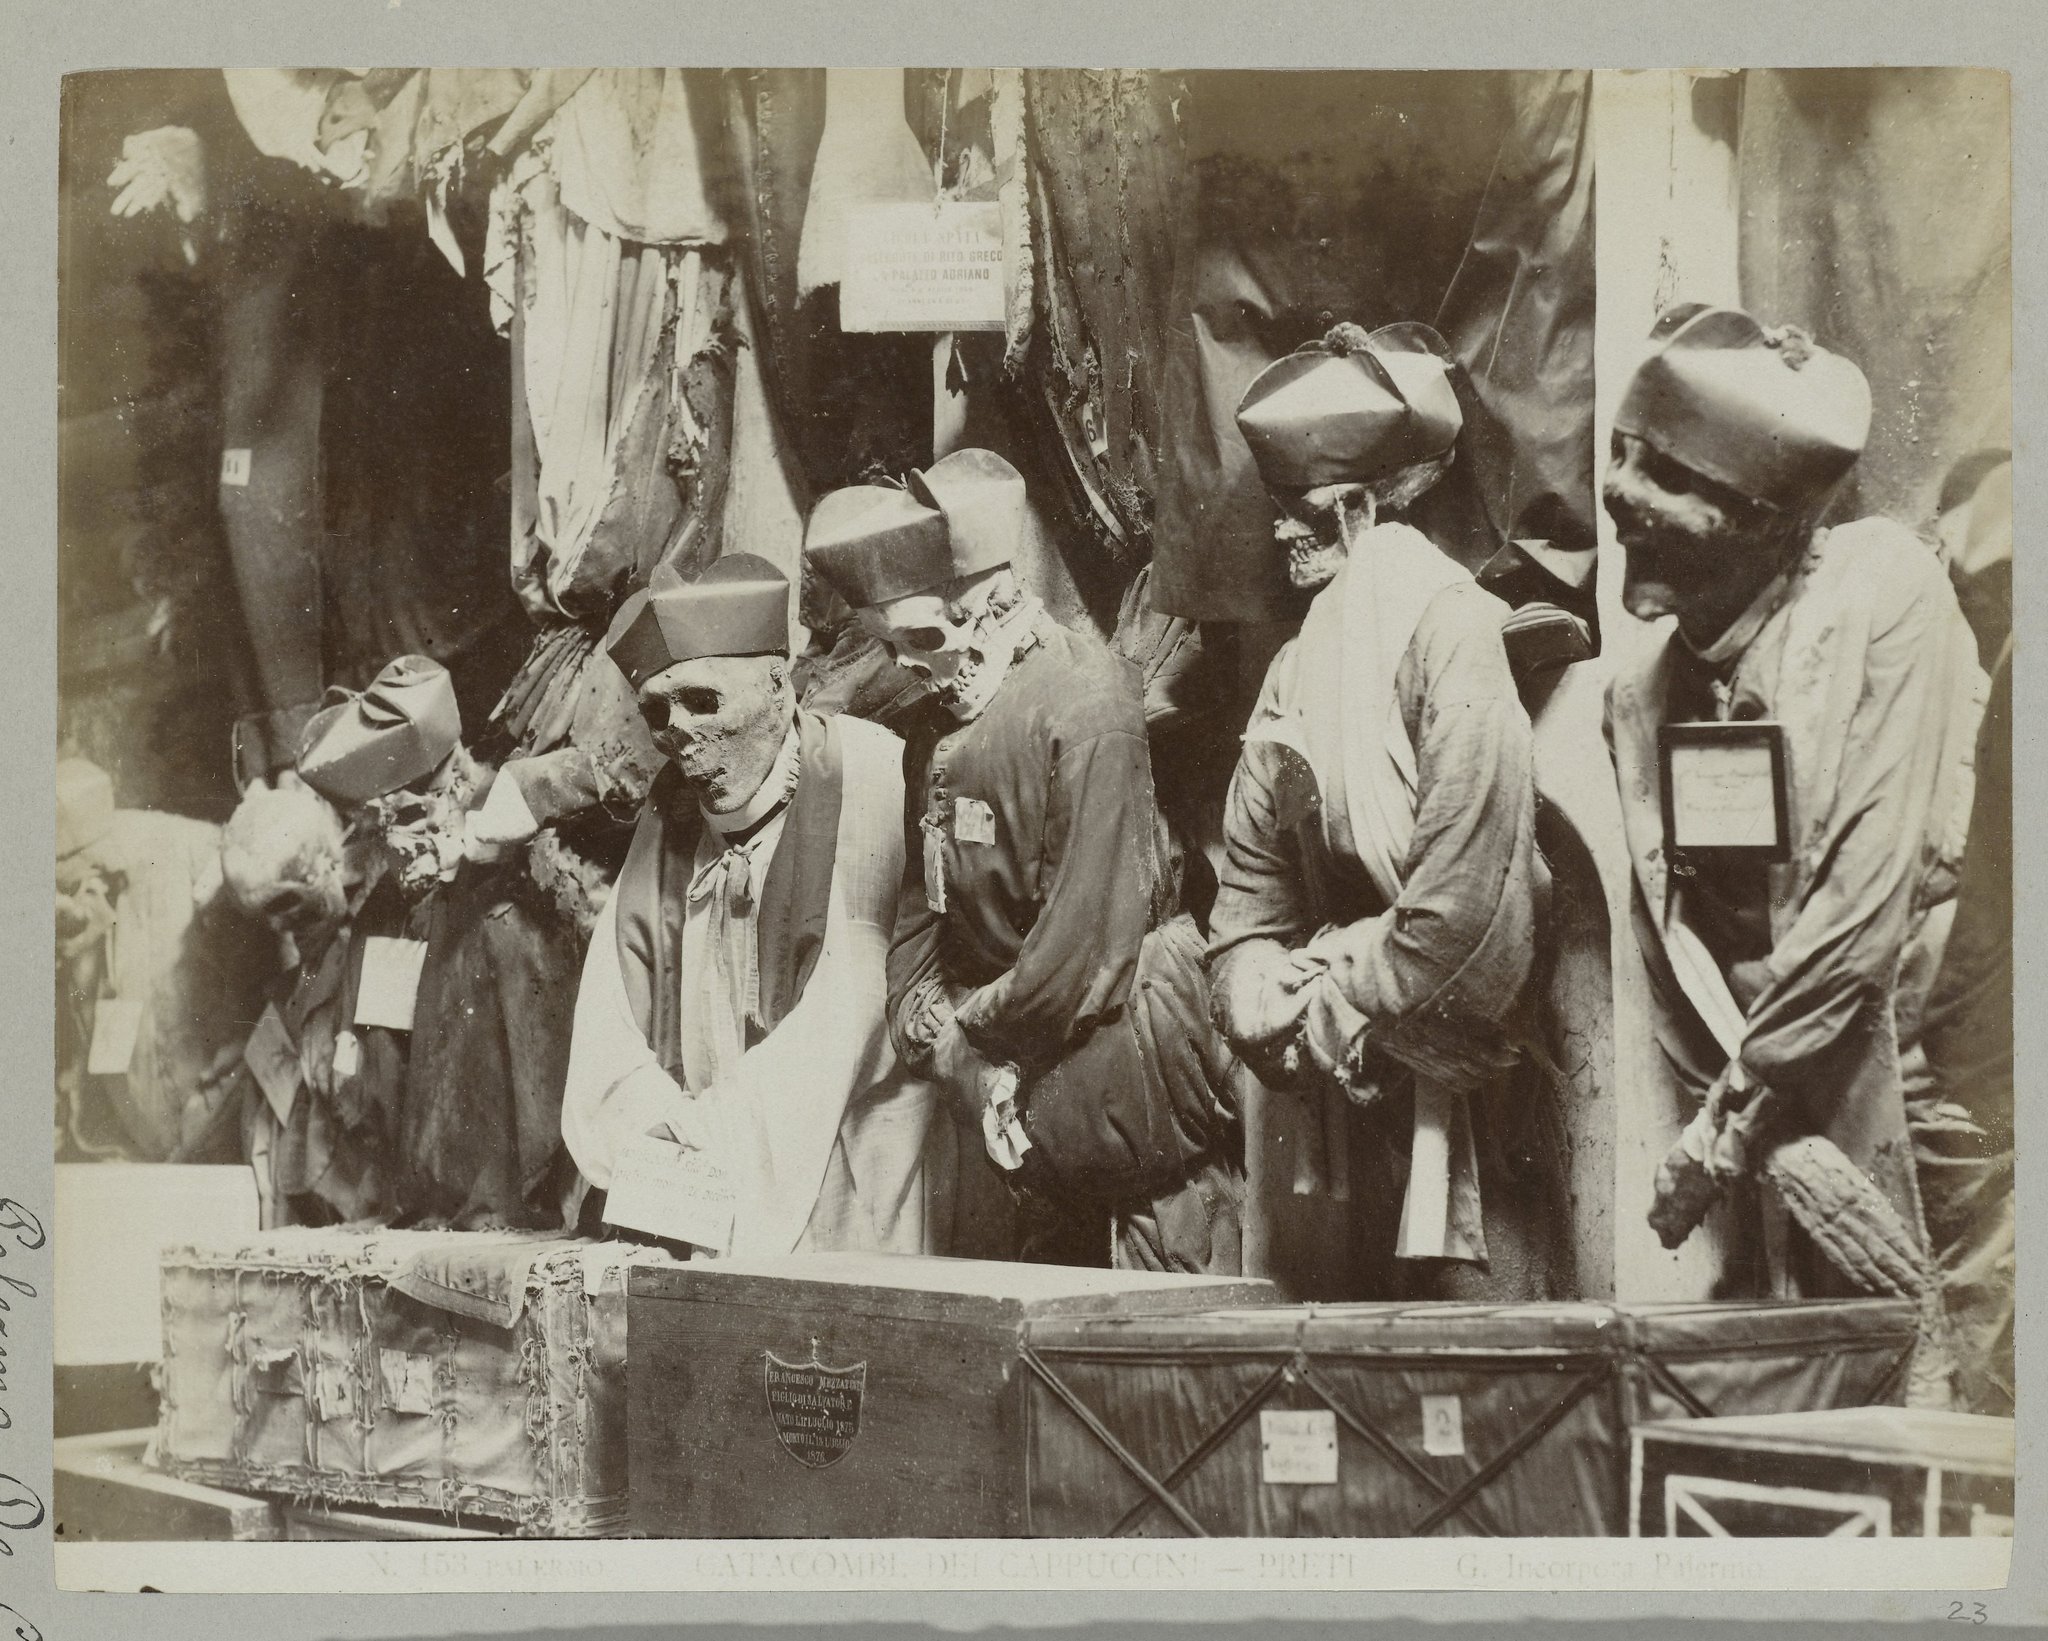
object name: photograph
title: Palermo de catacomben der Capucini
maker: giuseppe incorpora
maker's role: fotograaf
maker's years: 1834-1914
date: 1893-1903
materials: cardboard, photographic support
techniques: albumen print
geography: netherlands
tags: palermo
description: De catacomben der Capucijner monniken met aan de wanden van de catacomben de lichamen van overleden capucijner priesters.